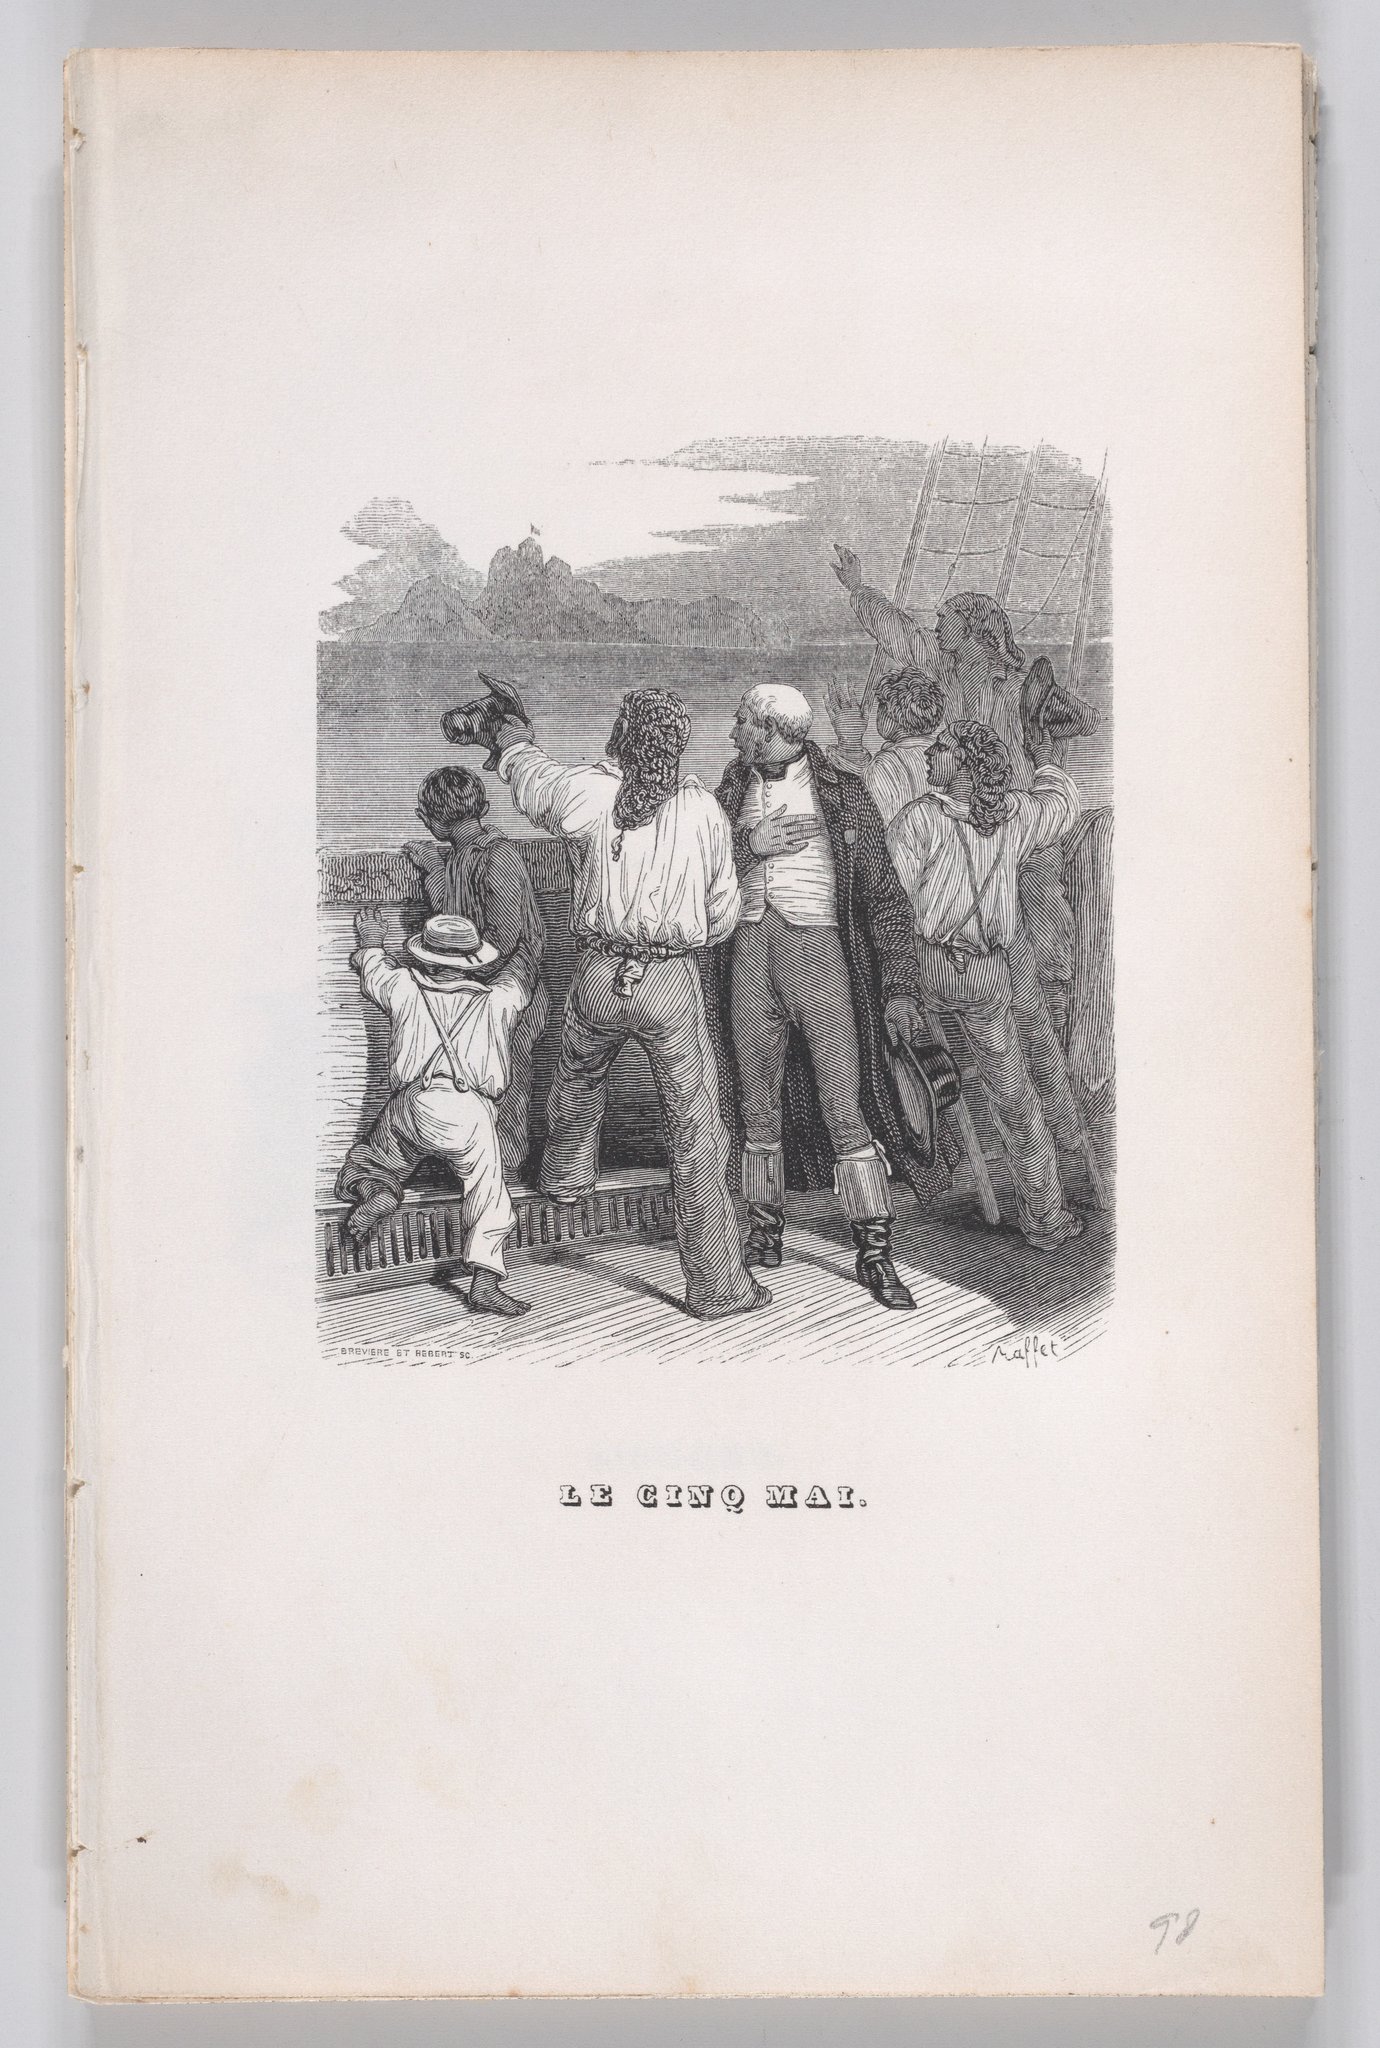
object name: print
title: The Fifth of May, from "The Complete Works of Béranger"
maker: j. j. grandville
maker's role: illustrator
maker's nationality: french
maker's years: 1803-1847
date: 1836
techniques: engraving